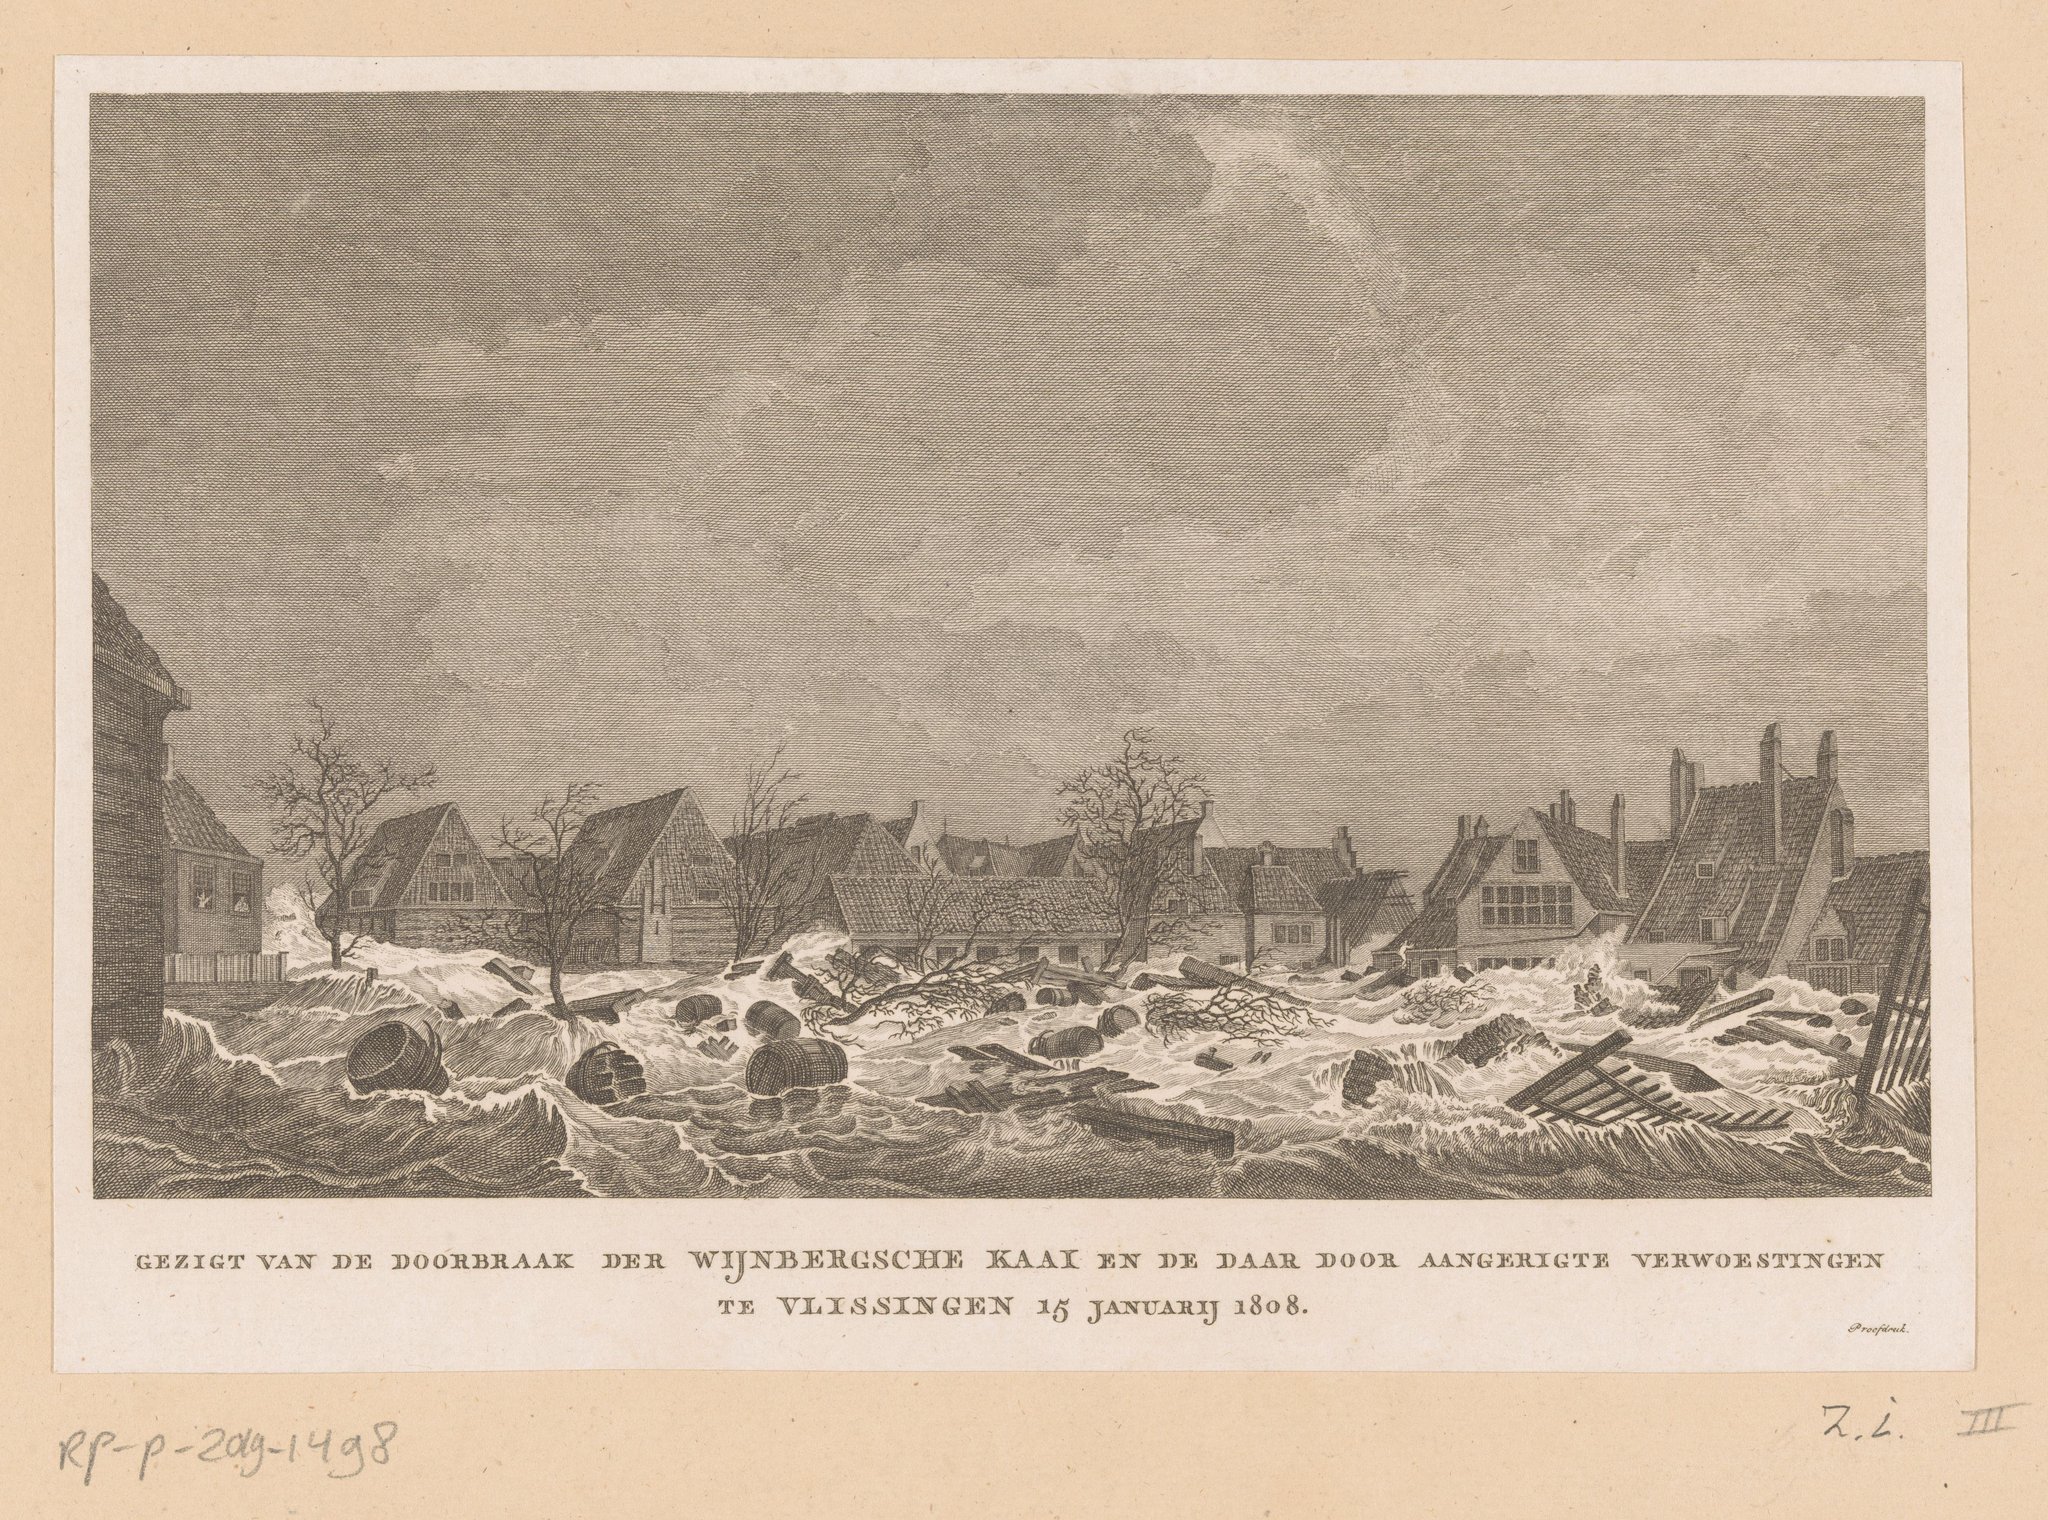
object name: print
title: Doorbraak van de Wijnbergse Kade te Vlissingen, 1808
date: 1808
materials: paper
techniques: etching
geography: netherlands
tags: dike-break, flood, flushing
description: Prent uit: Hoek, S. van. Natuur- en geschiedkundige beschrijving van den verschrikkelijken watervloed tusschen den XIVden en XVden van Louwmaand des jaars 1808. Haarlem: Adriaan Pietersz. Loosjes, 1808, tussen p. 164 en 165.